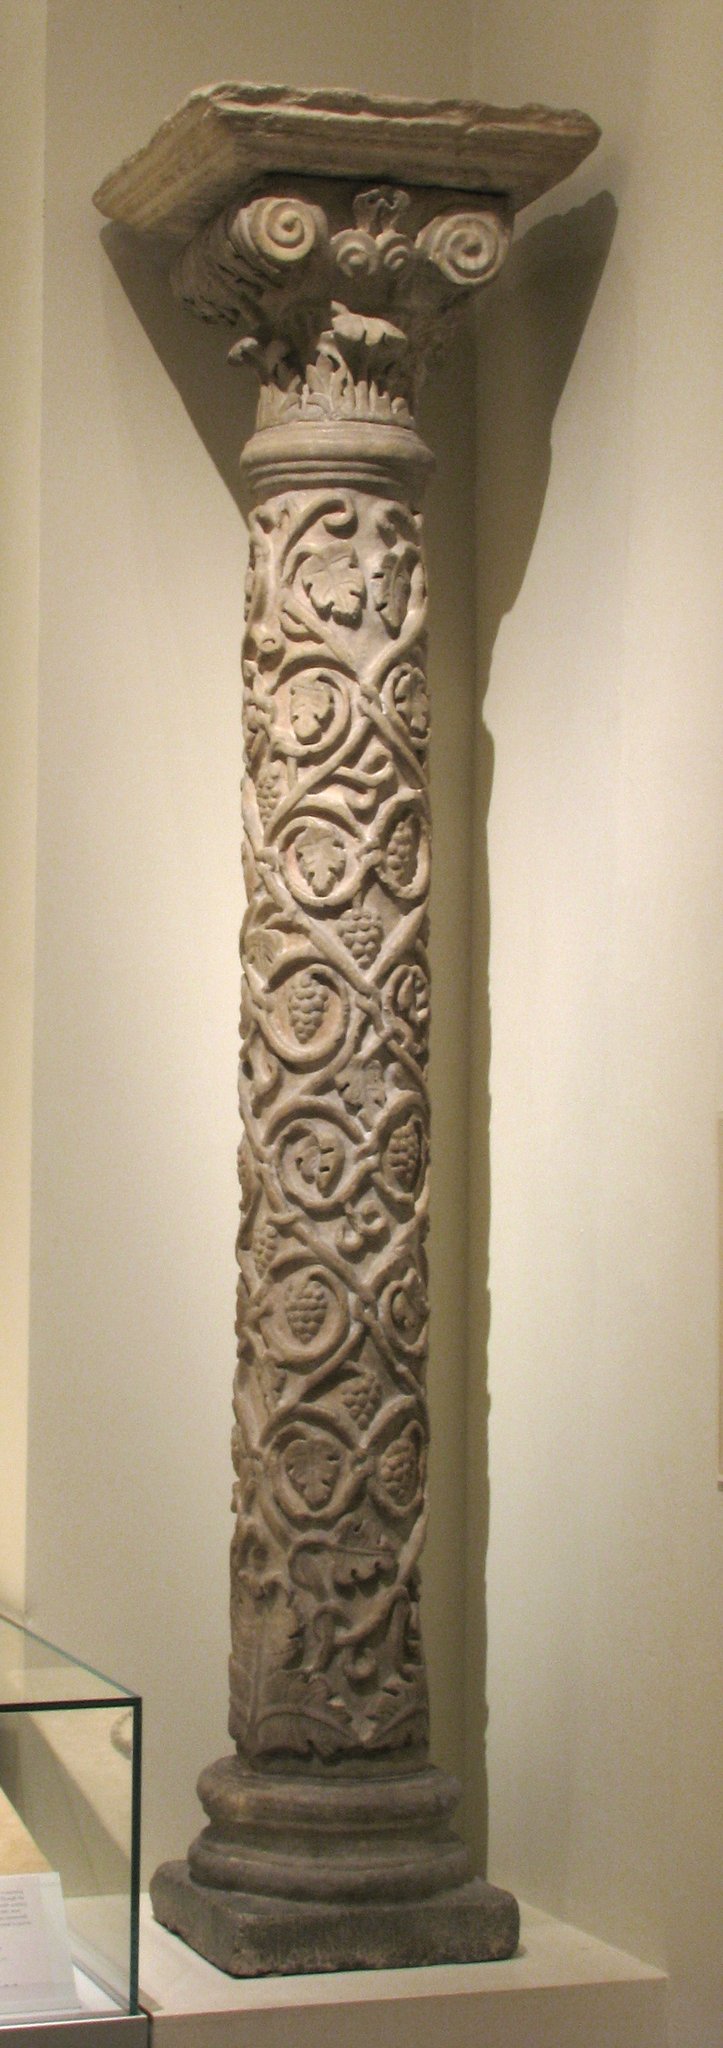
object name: column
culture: frankish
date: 401-600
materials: marble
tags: grapes